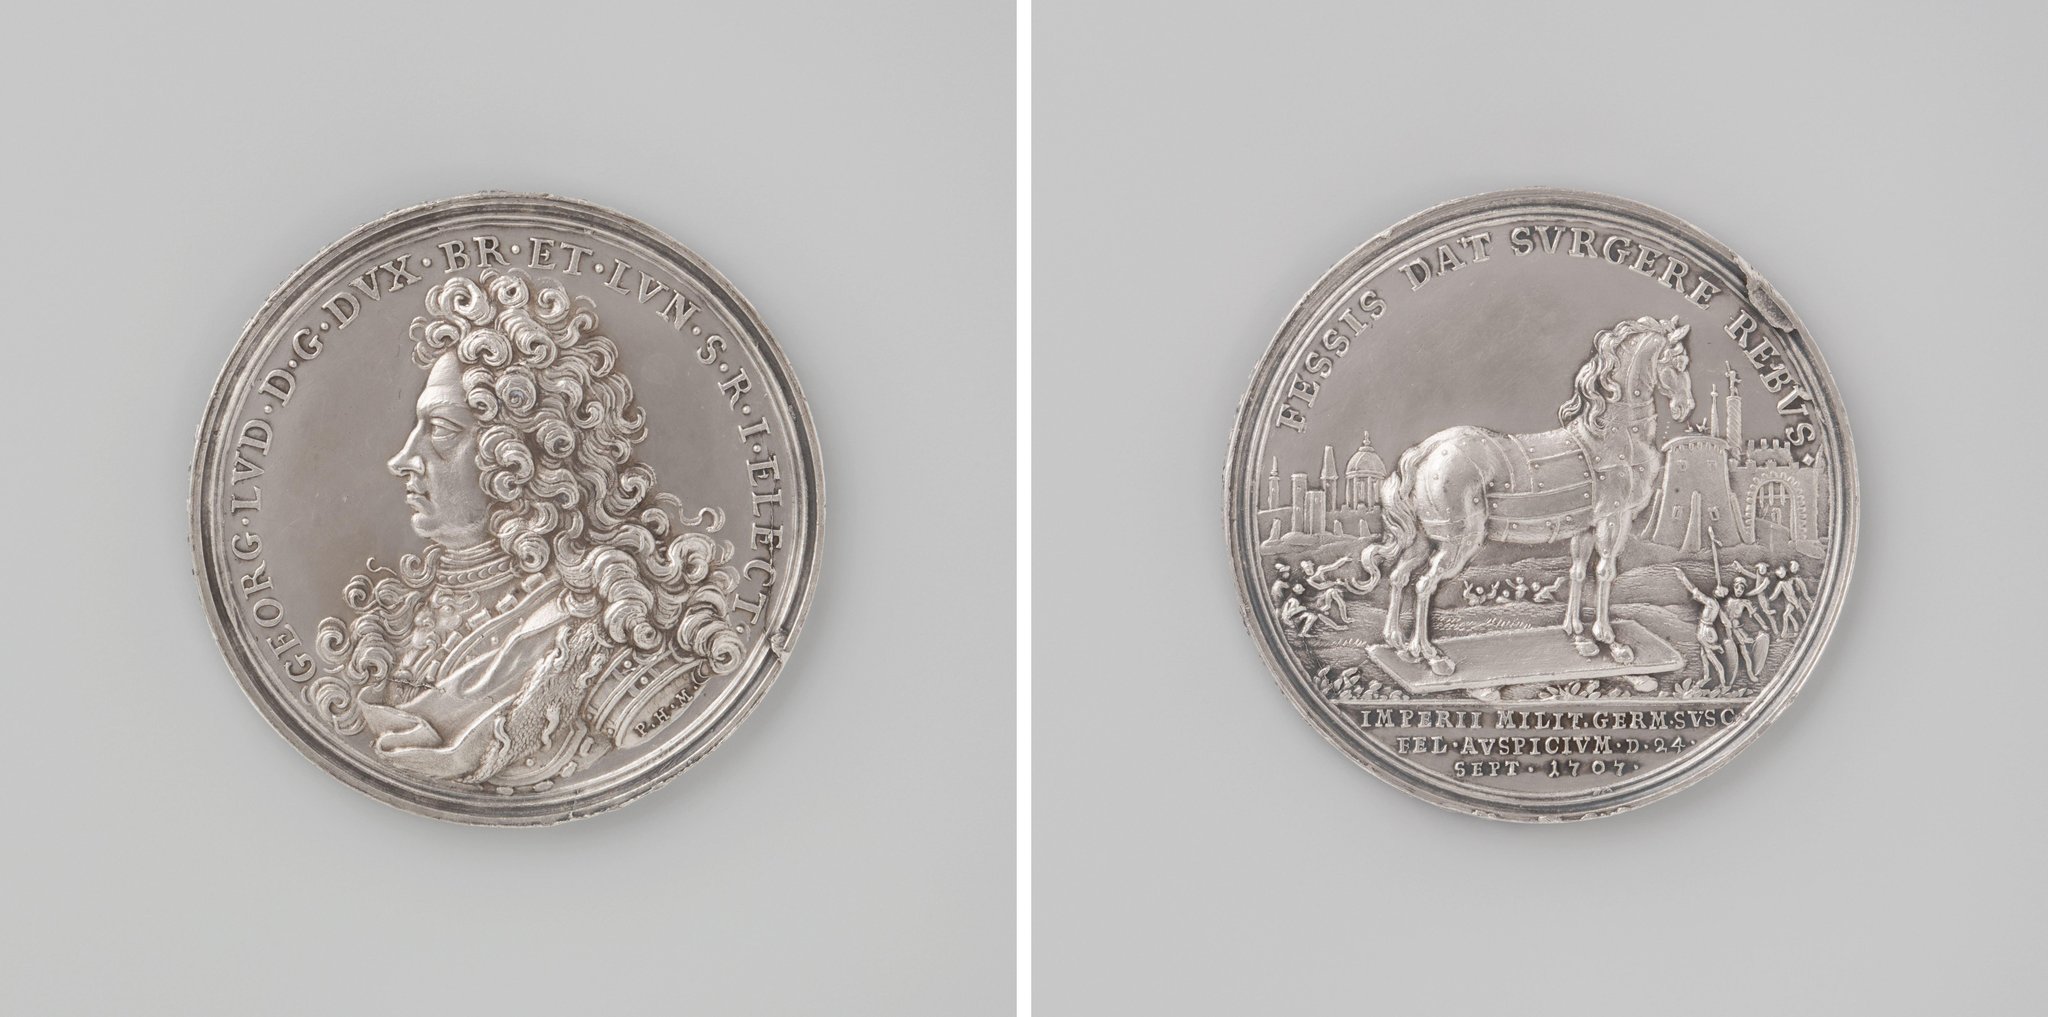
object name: history medal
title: George Lodewijk van Braunschweig en Lueneburg benoemd tot opperbevelhebber over het keizerlijke leger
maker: philipp heinrich müller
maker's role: medailleur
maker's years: 1654-1719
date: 1707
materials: silver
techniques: striking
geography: nuremberg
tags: george i (koning van groot-brittannië en ierland)